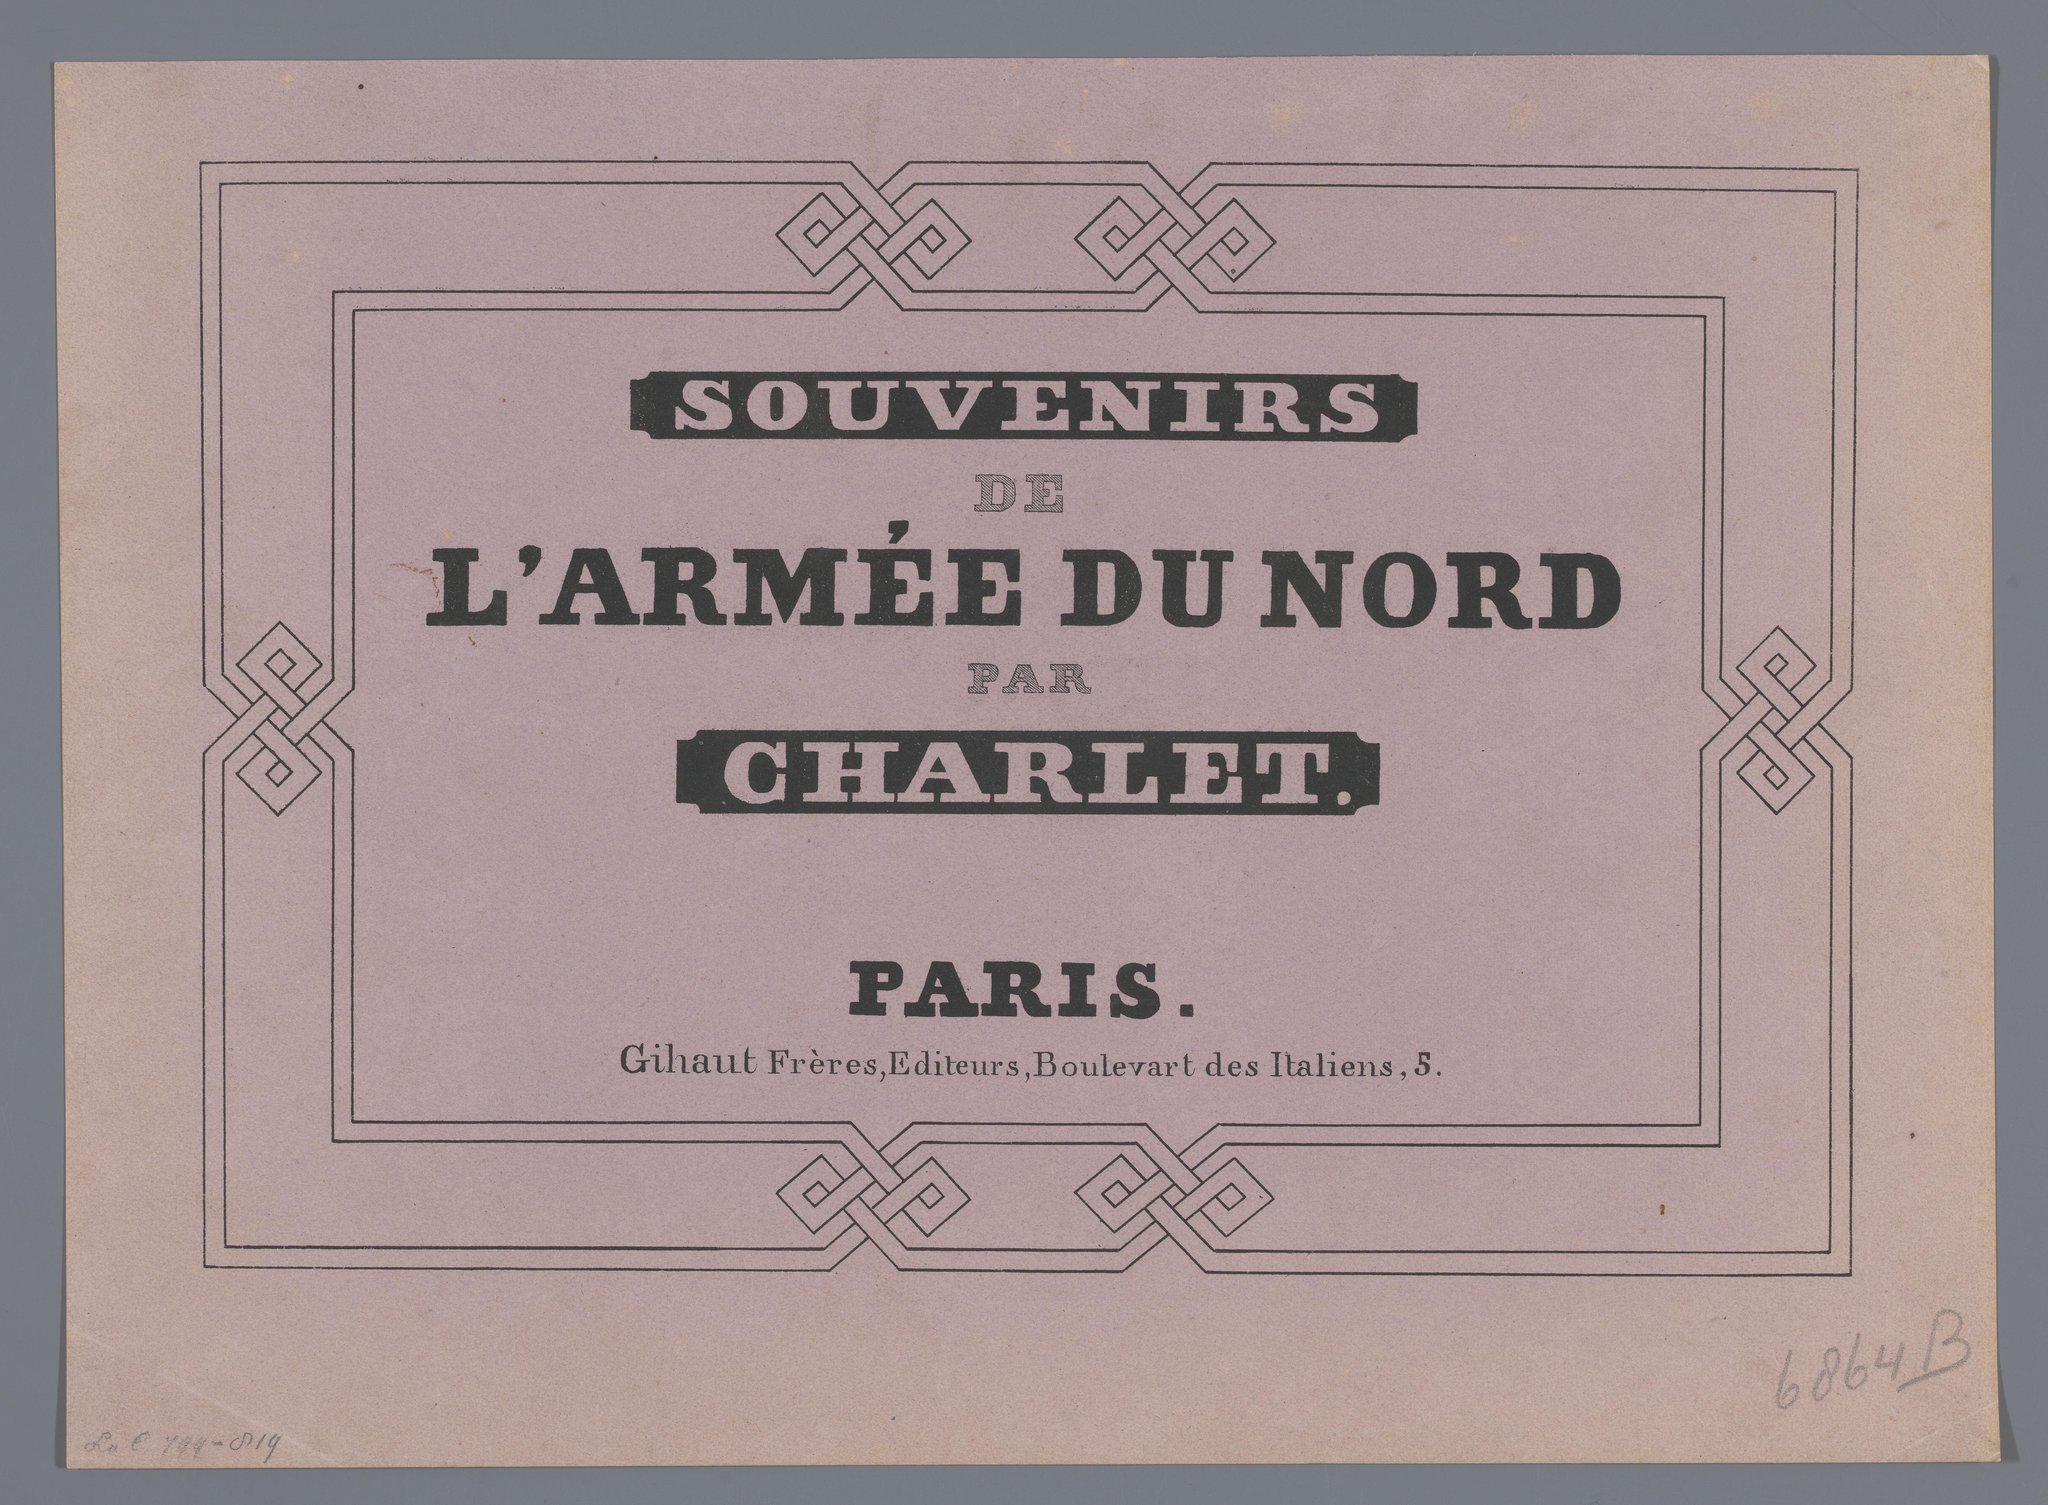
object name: titelblad, titelpagina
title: Souvenirs de L'Armée du Nord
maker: nicolas toussaint charlet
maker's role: draughtsman, painter, print maker, printer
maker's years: 1792-1845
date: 1832-1833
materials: paper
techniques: lithograph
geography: paris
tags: antwerp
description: Typografisch titelblad voor een serie van twintig bladen uit 1833 met voorstellingen van de militaire interventie van het Franse Noordelijke Leger in België in 1832.